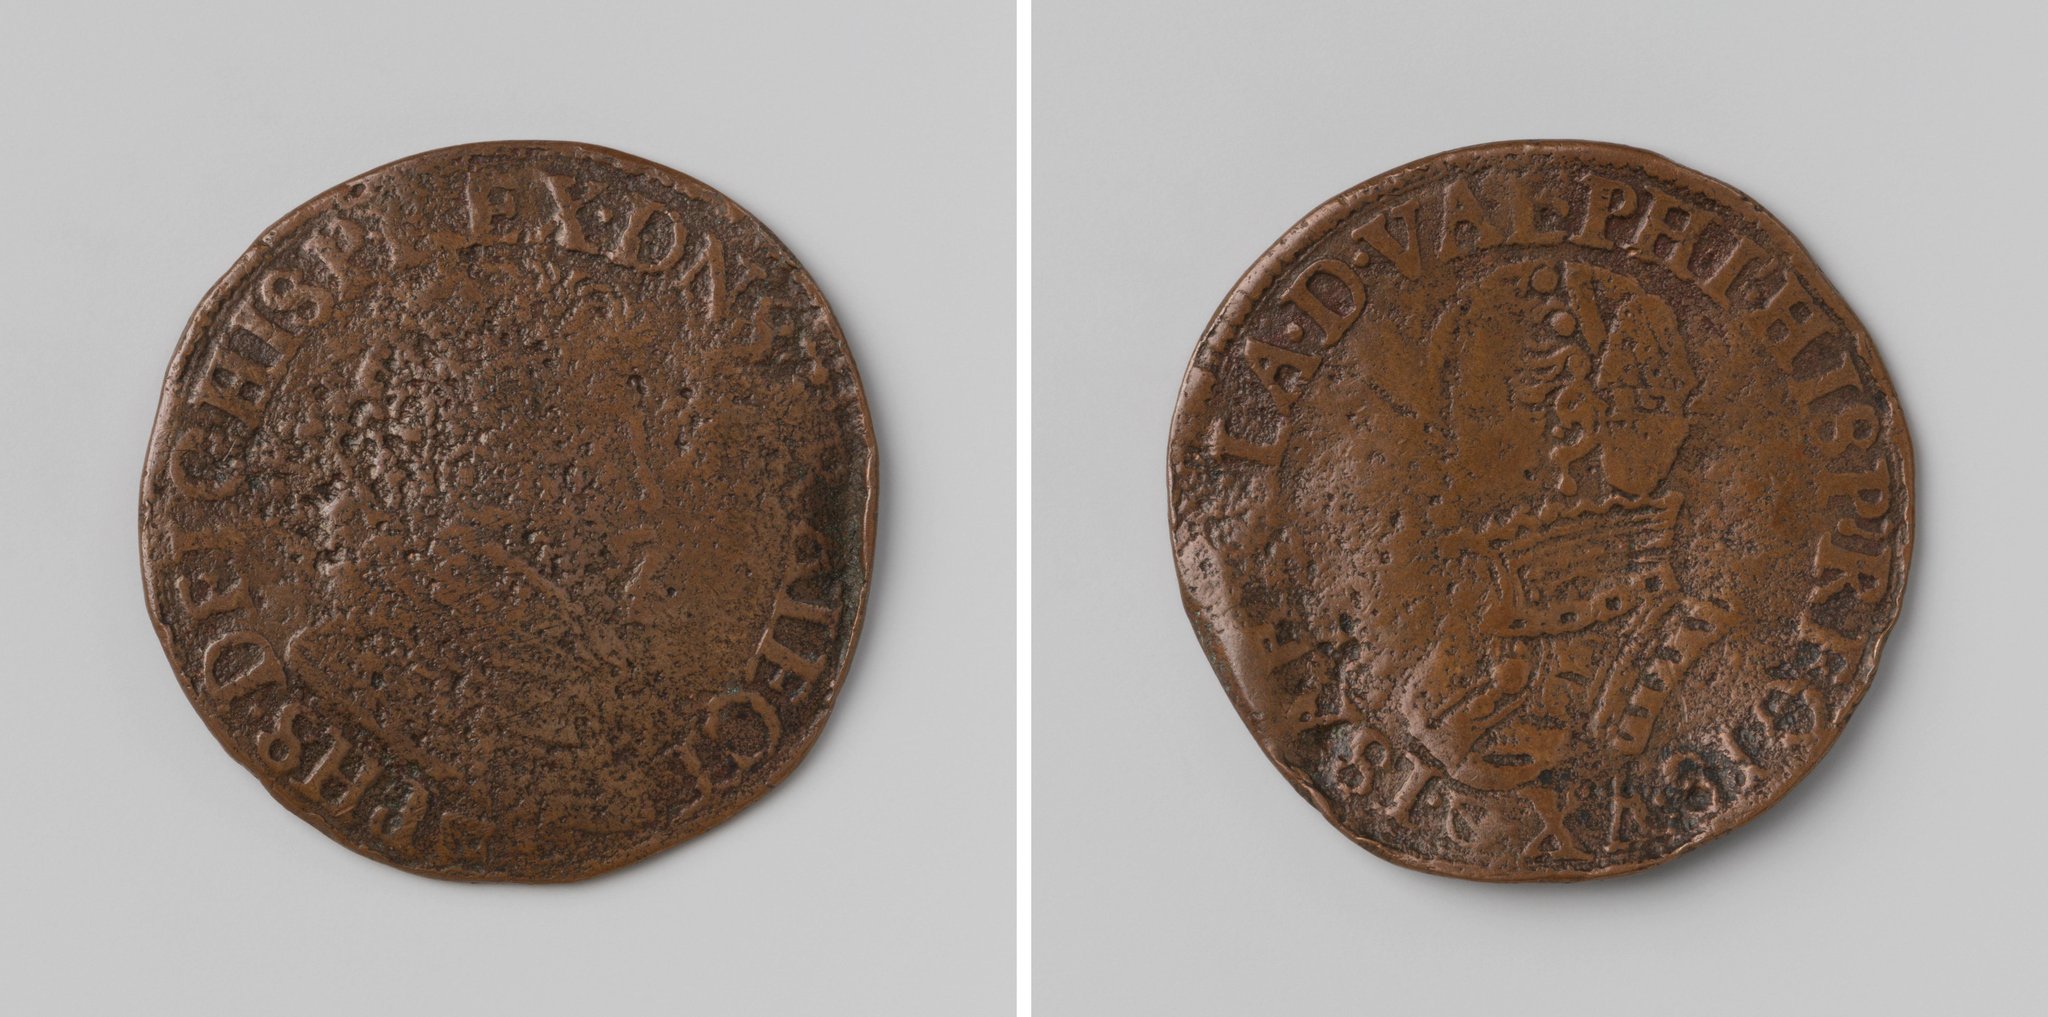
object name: jeton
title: Huwelijk van Filips II, koning van Spanje en Elisabeth van Valois, overeenkomstig de voorwaarden van de vrede van Le Cateau-Cambresis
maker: Anonymous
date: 1559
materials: copper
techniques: striking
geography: utrecht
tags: philip ii of spain, utrecht, paris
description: Koperen penning. Voorzijde: borststuk man binnen omschrift. Keerzijde: borststuk vrouw binnen omschrift